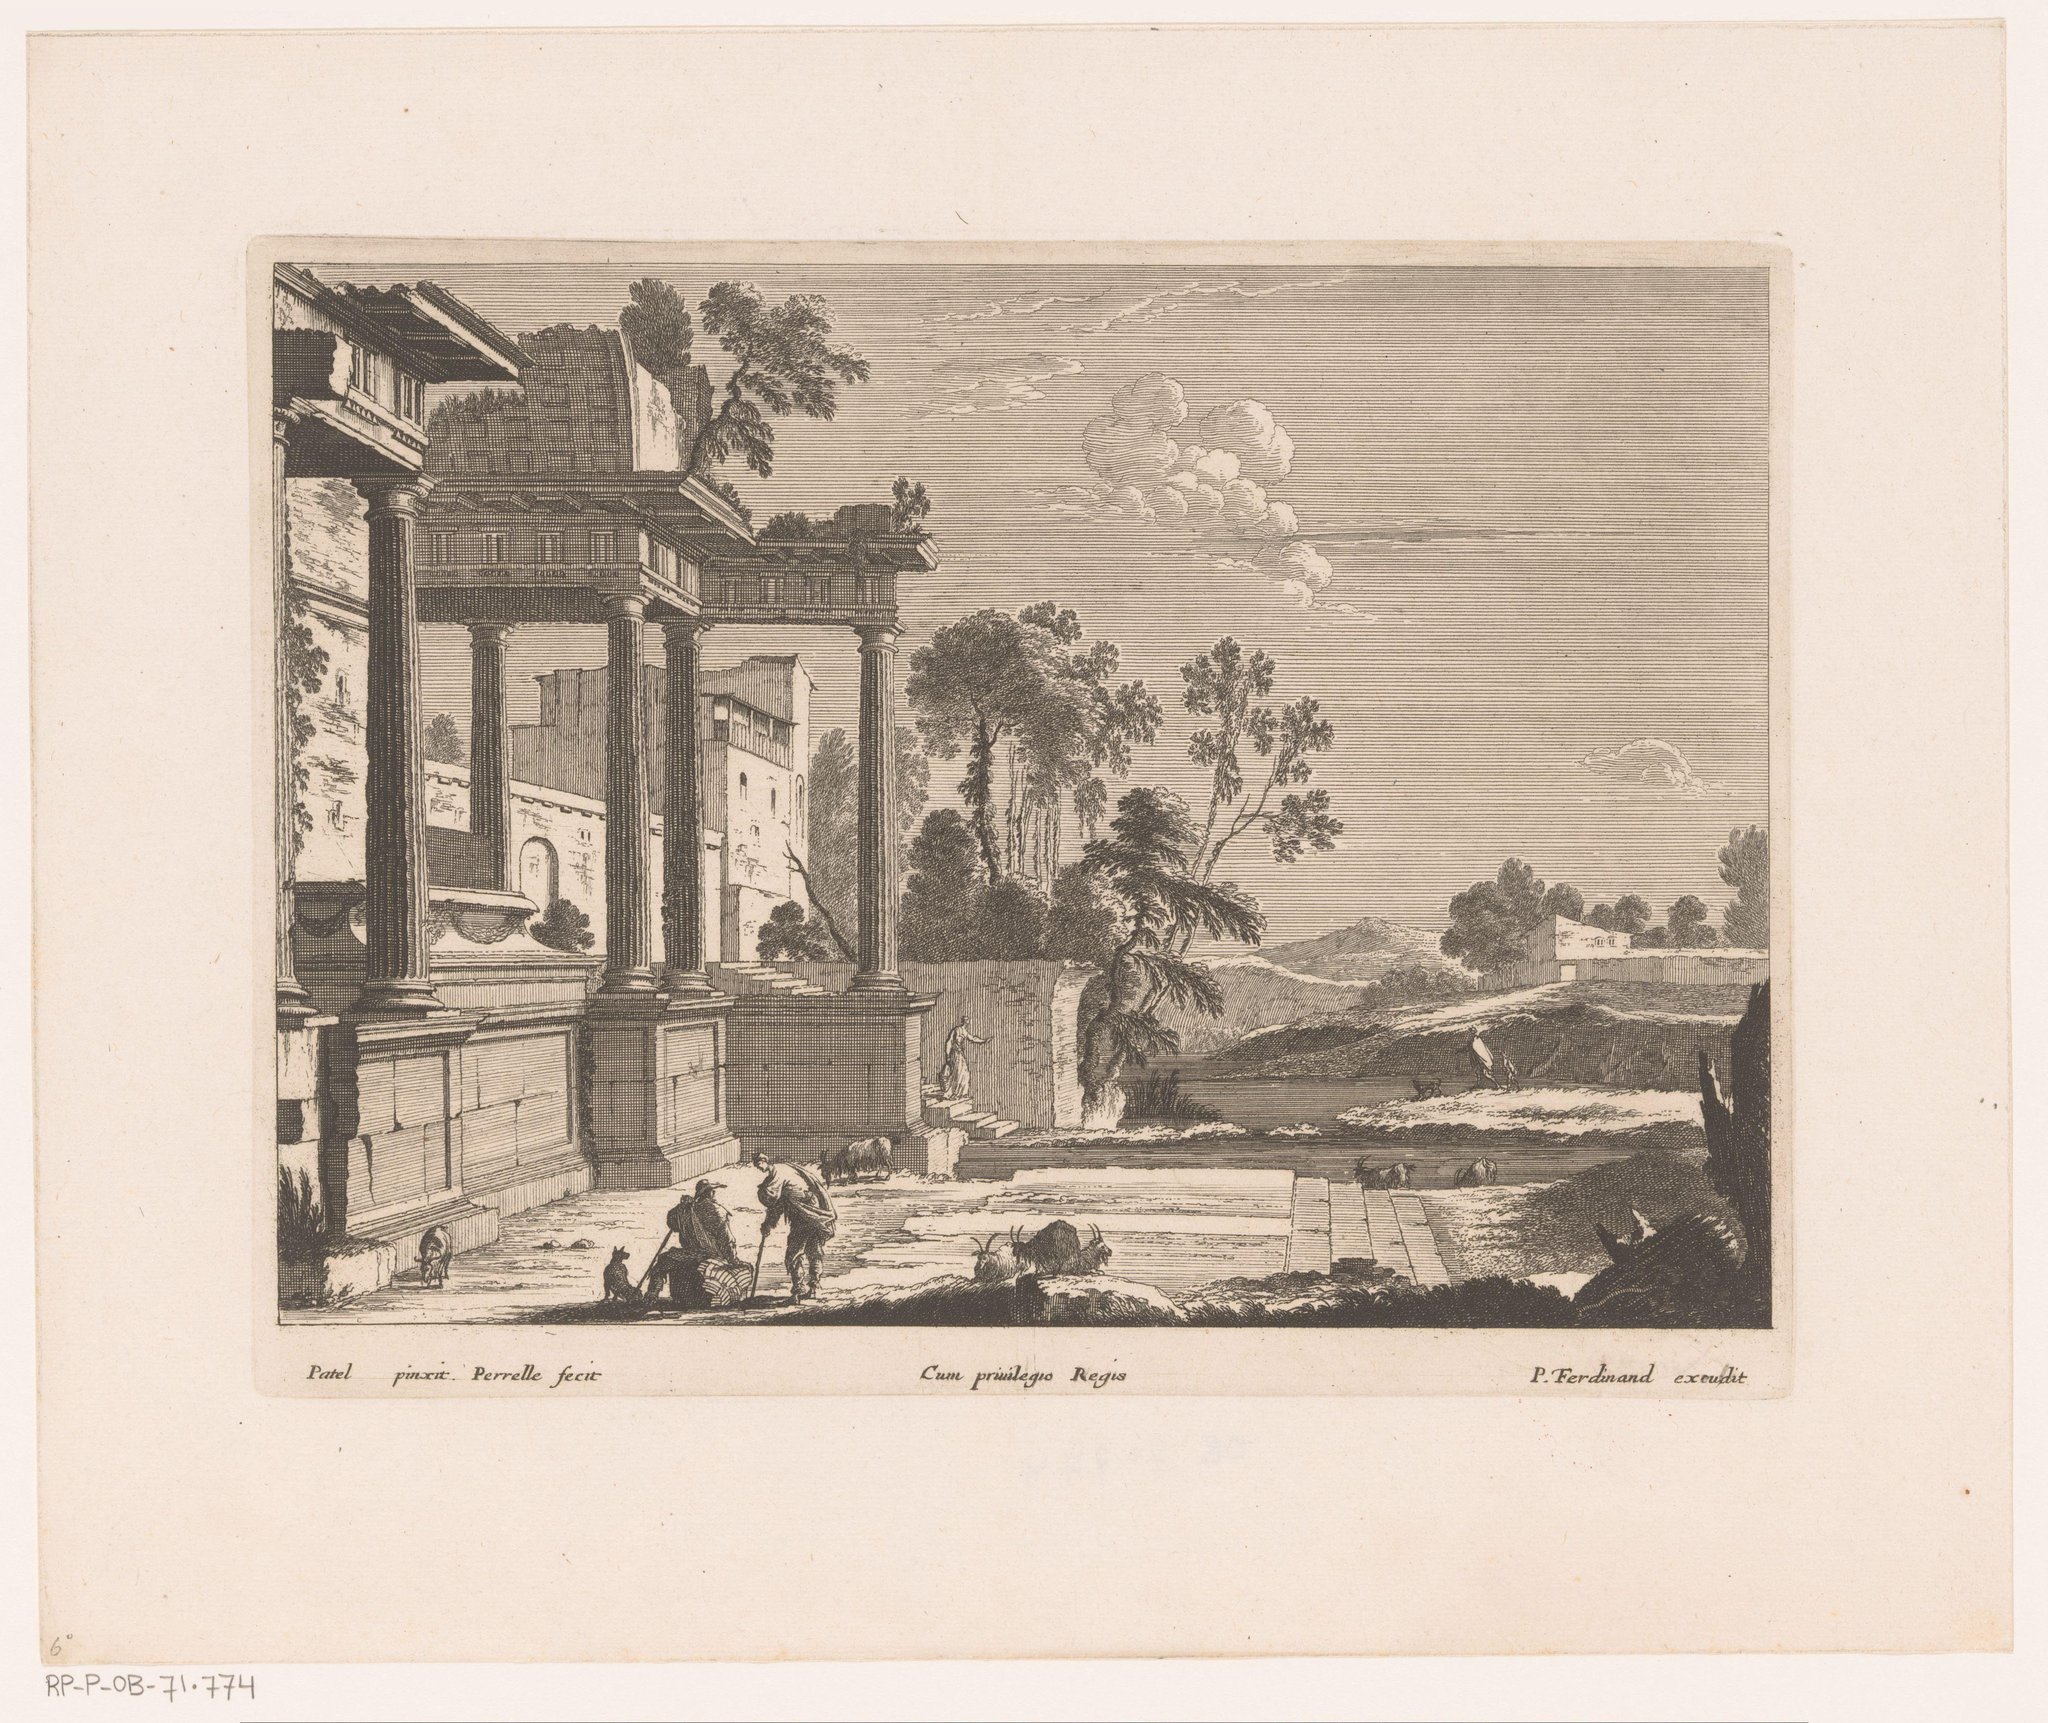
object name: print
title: Figuren en geiten bij antieke ruïne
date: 1627-1655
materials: paper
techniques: etching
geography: paris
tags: ruin of a building ~ architecture, landscape with ruins, goat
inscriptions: collector's mark: Lugt 240